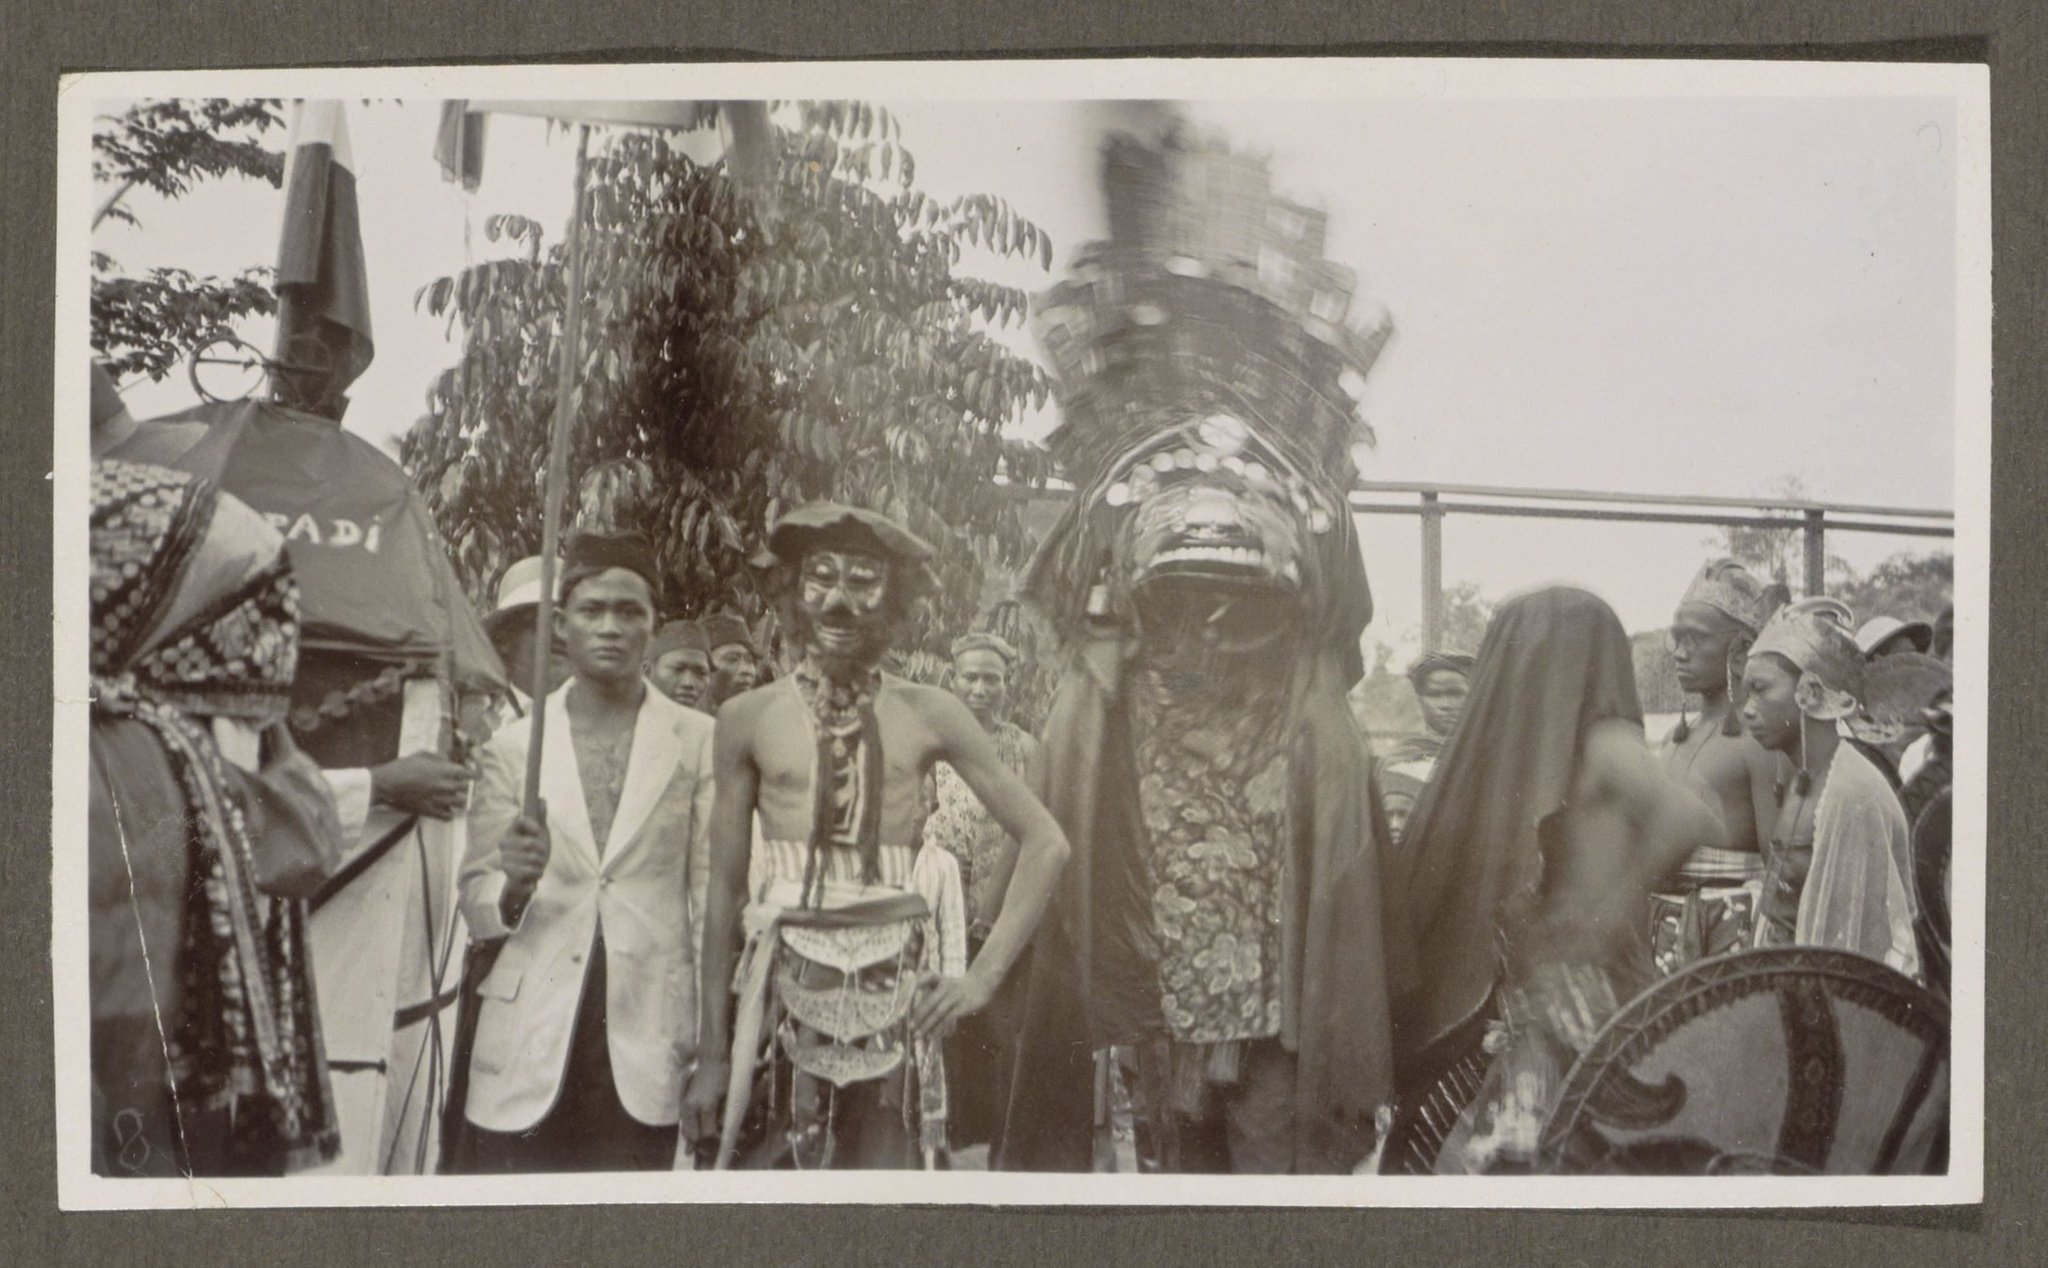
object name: photograph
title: Verklede en geschminkte deelnemers aan een optocht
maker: Anonymous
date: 1920-1930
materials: photographic support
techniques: gelatin silver print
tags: public festivities at birth of royal persons, dutch east indies, the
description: Onderdeel van familiealbum Nederlands-Indië.